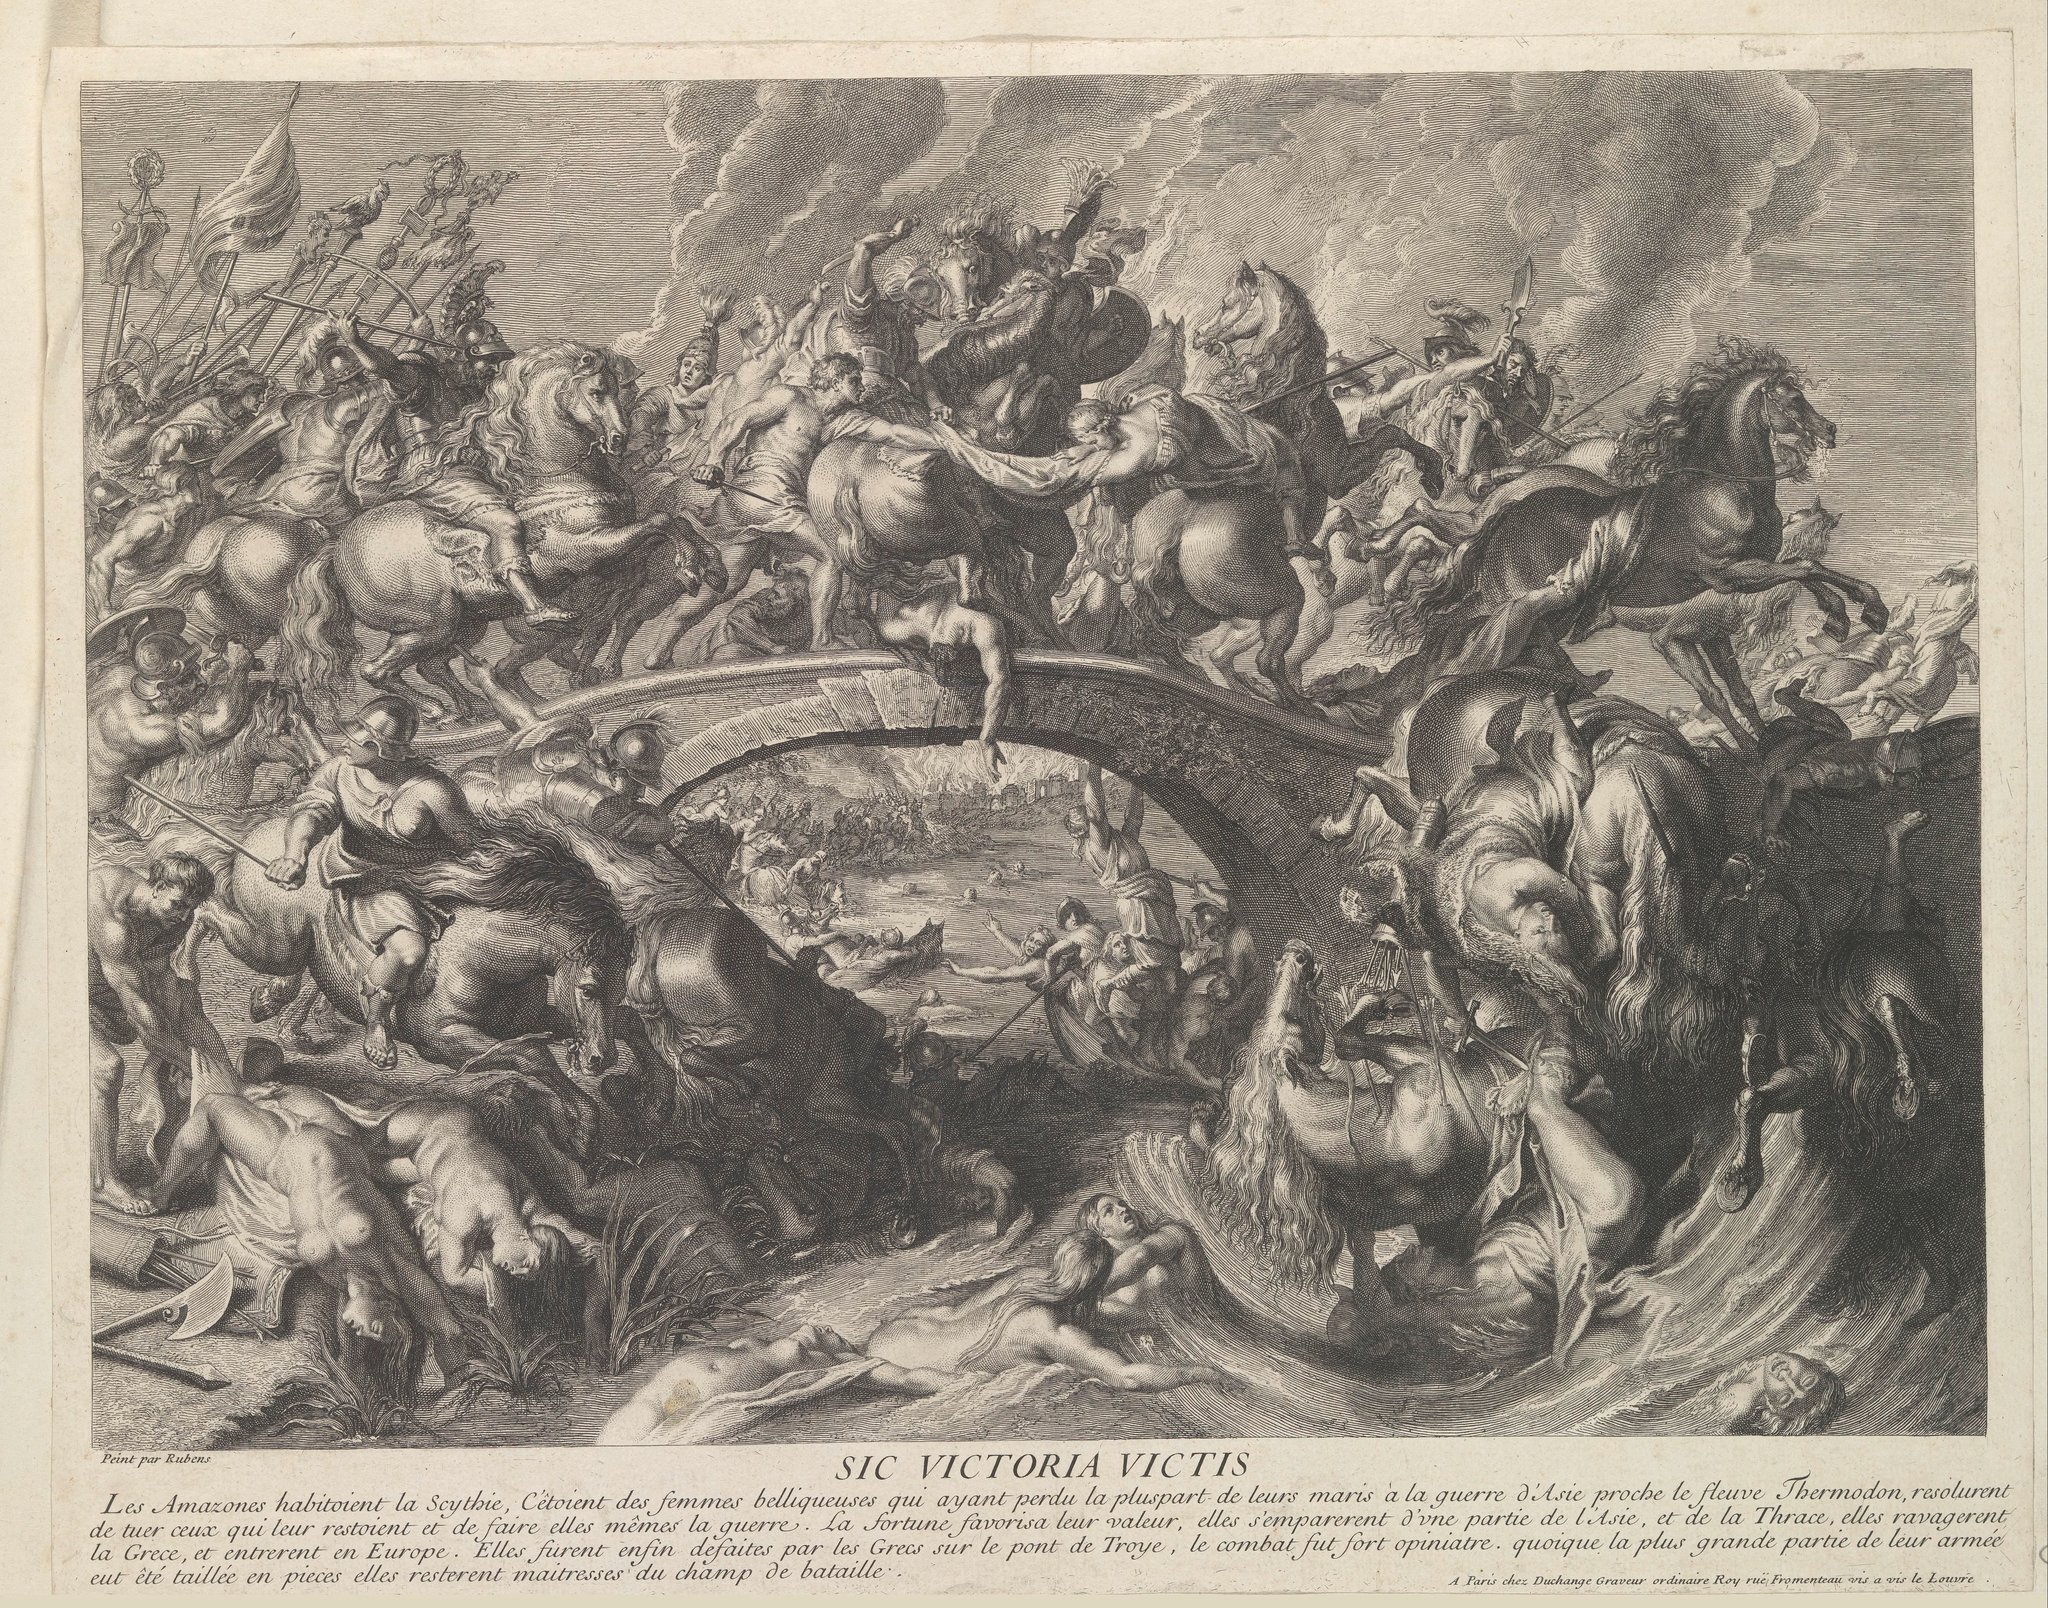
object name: print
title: Gevecht met Amazones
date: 1700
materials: paper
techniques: engraving, etching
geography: paris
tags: battle of amazons; amazonomachy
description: Amazonenslag op een brug. Deze prent maakt deel uit van een album.